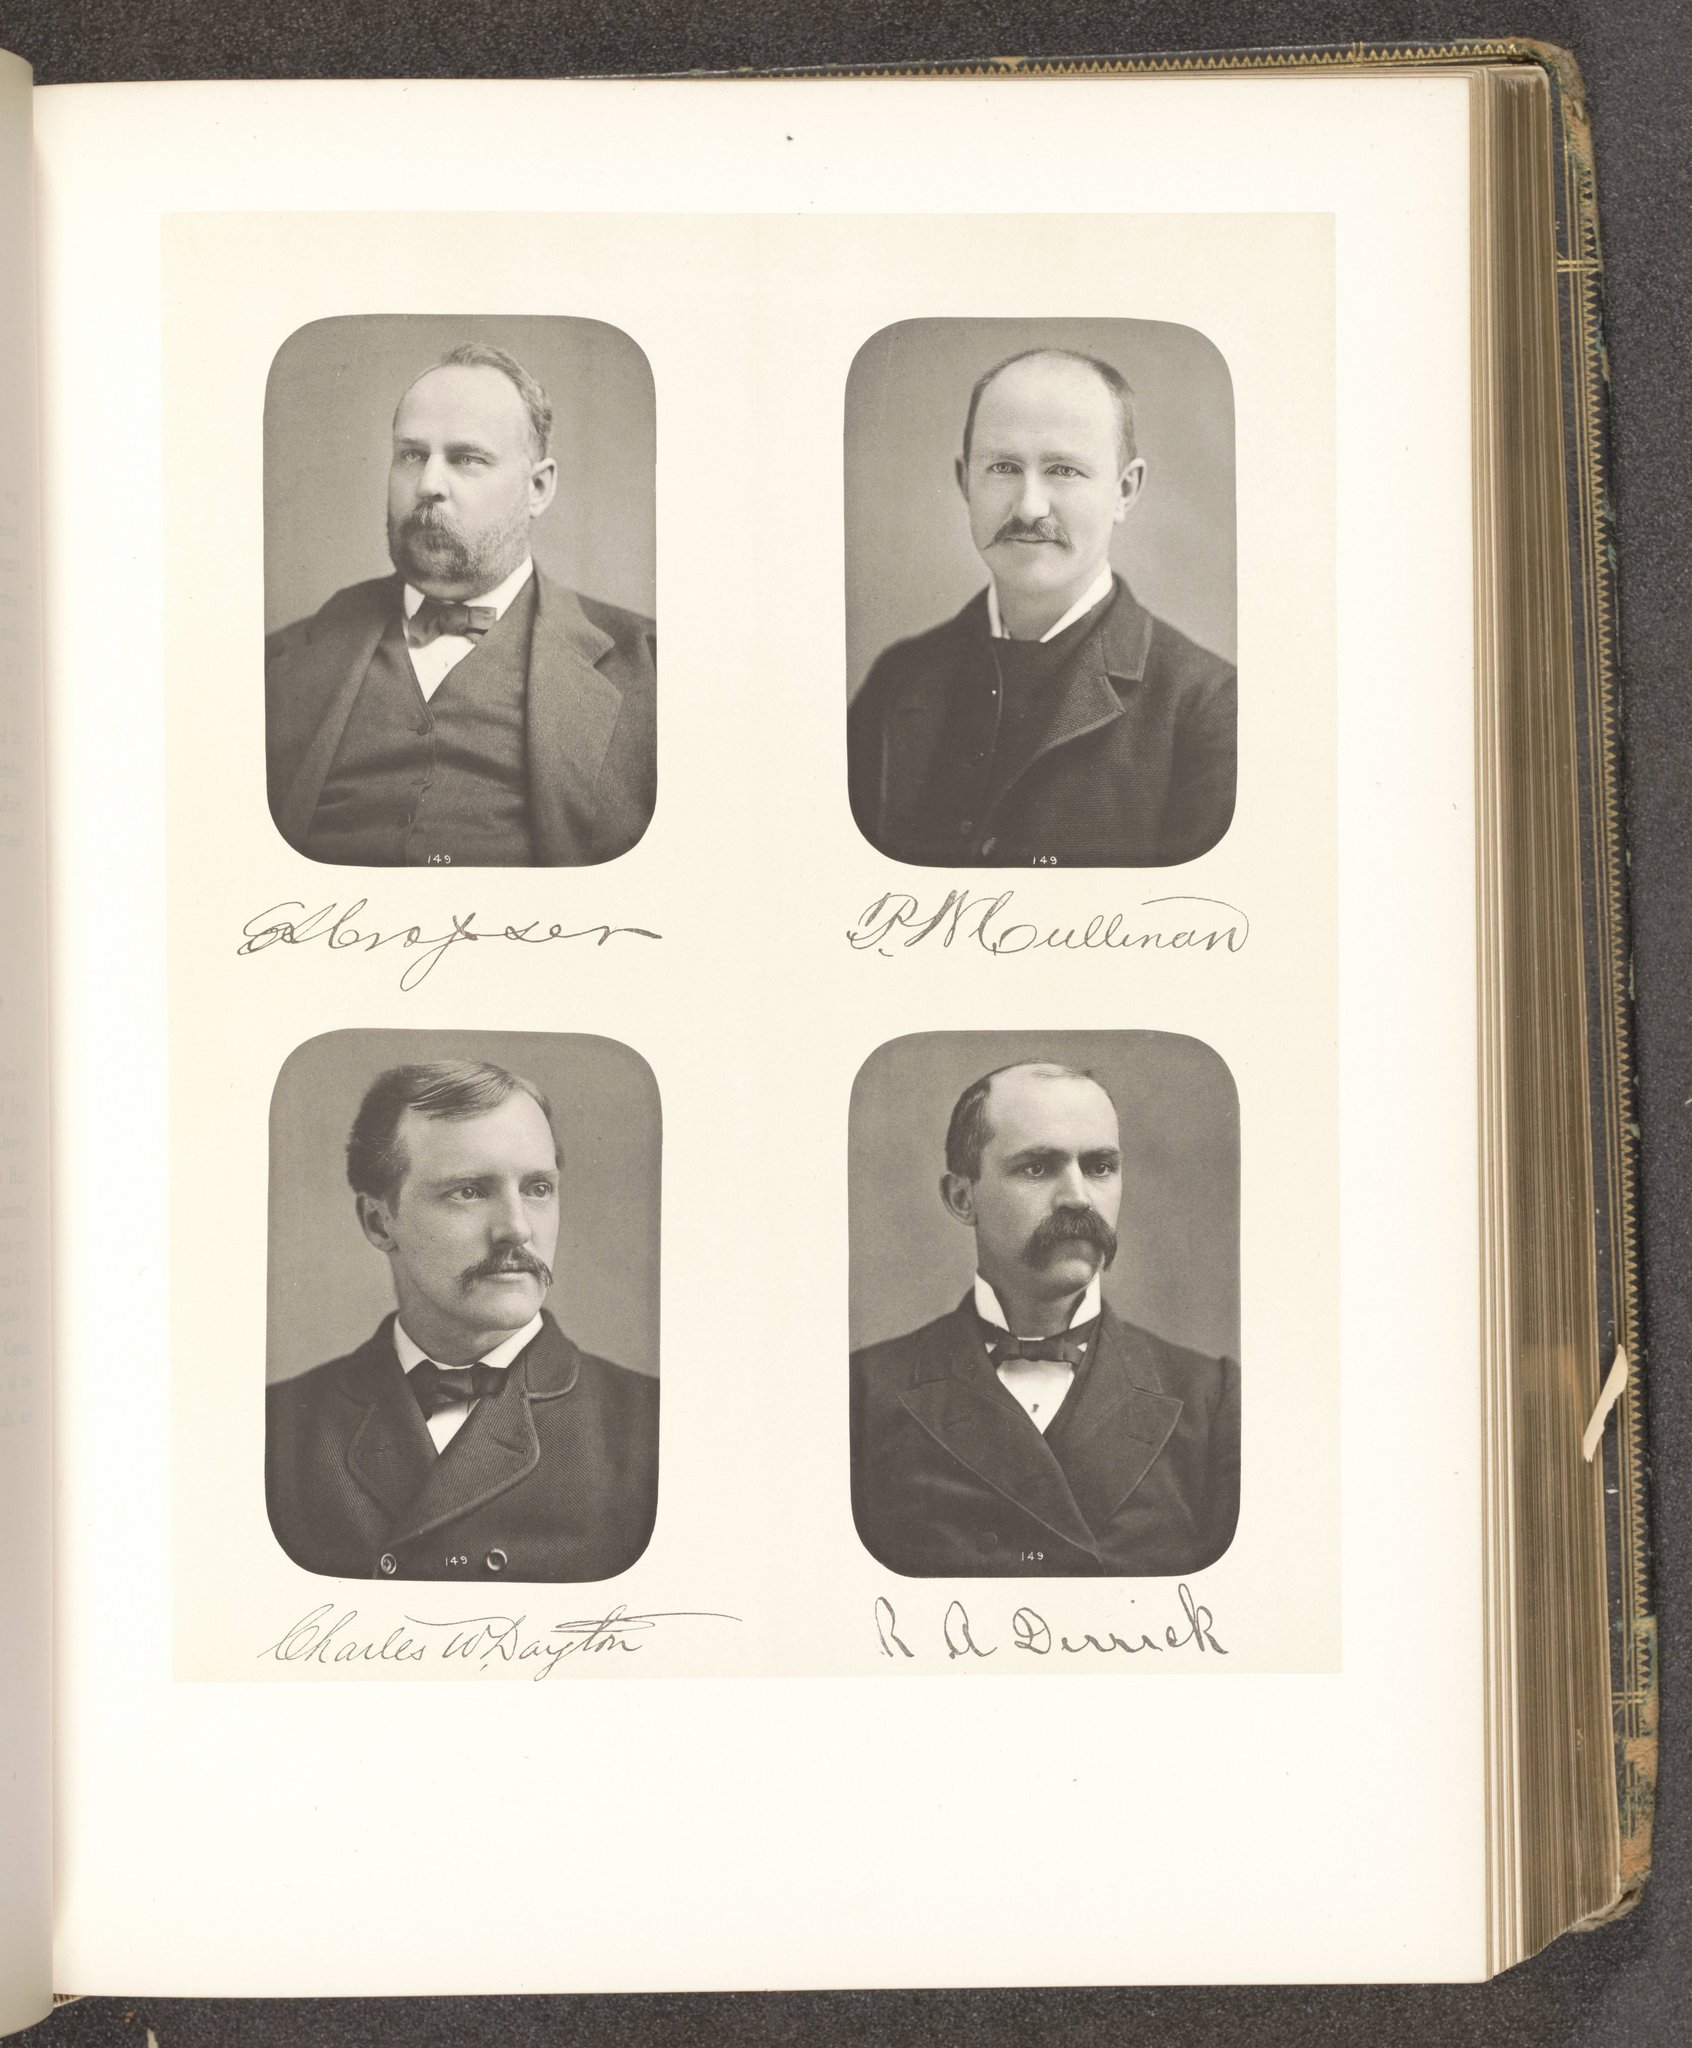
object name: page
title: Portretten van vier leden van het Lagerhuis van de staat New York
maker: Anonymous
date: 1872-1882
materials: paper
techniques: photograph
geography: united states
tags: historical persons (portraits and scenes from the life) (+ head (and shoulders) (portrait))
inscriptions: annotation, number: ‘149’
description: Linksboven Ebenezer S. Crapser, rechtsboven Patrick W. Cullinan, linksonder Charles W. Dayton, rechtsonder Richard A. Derrick.